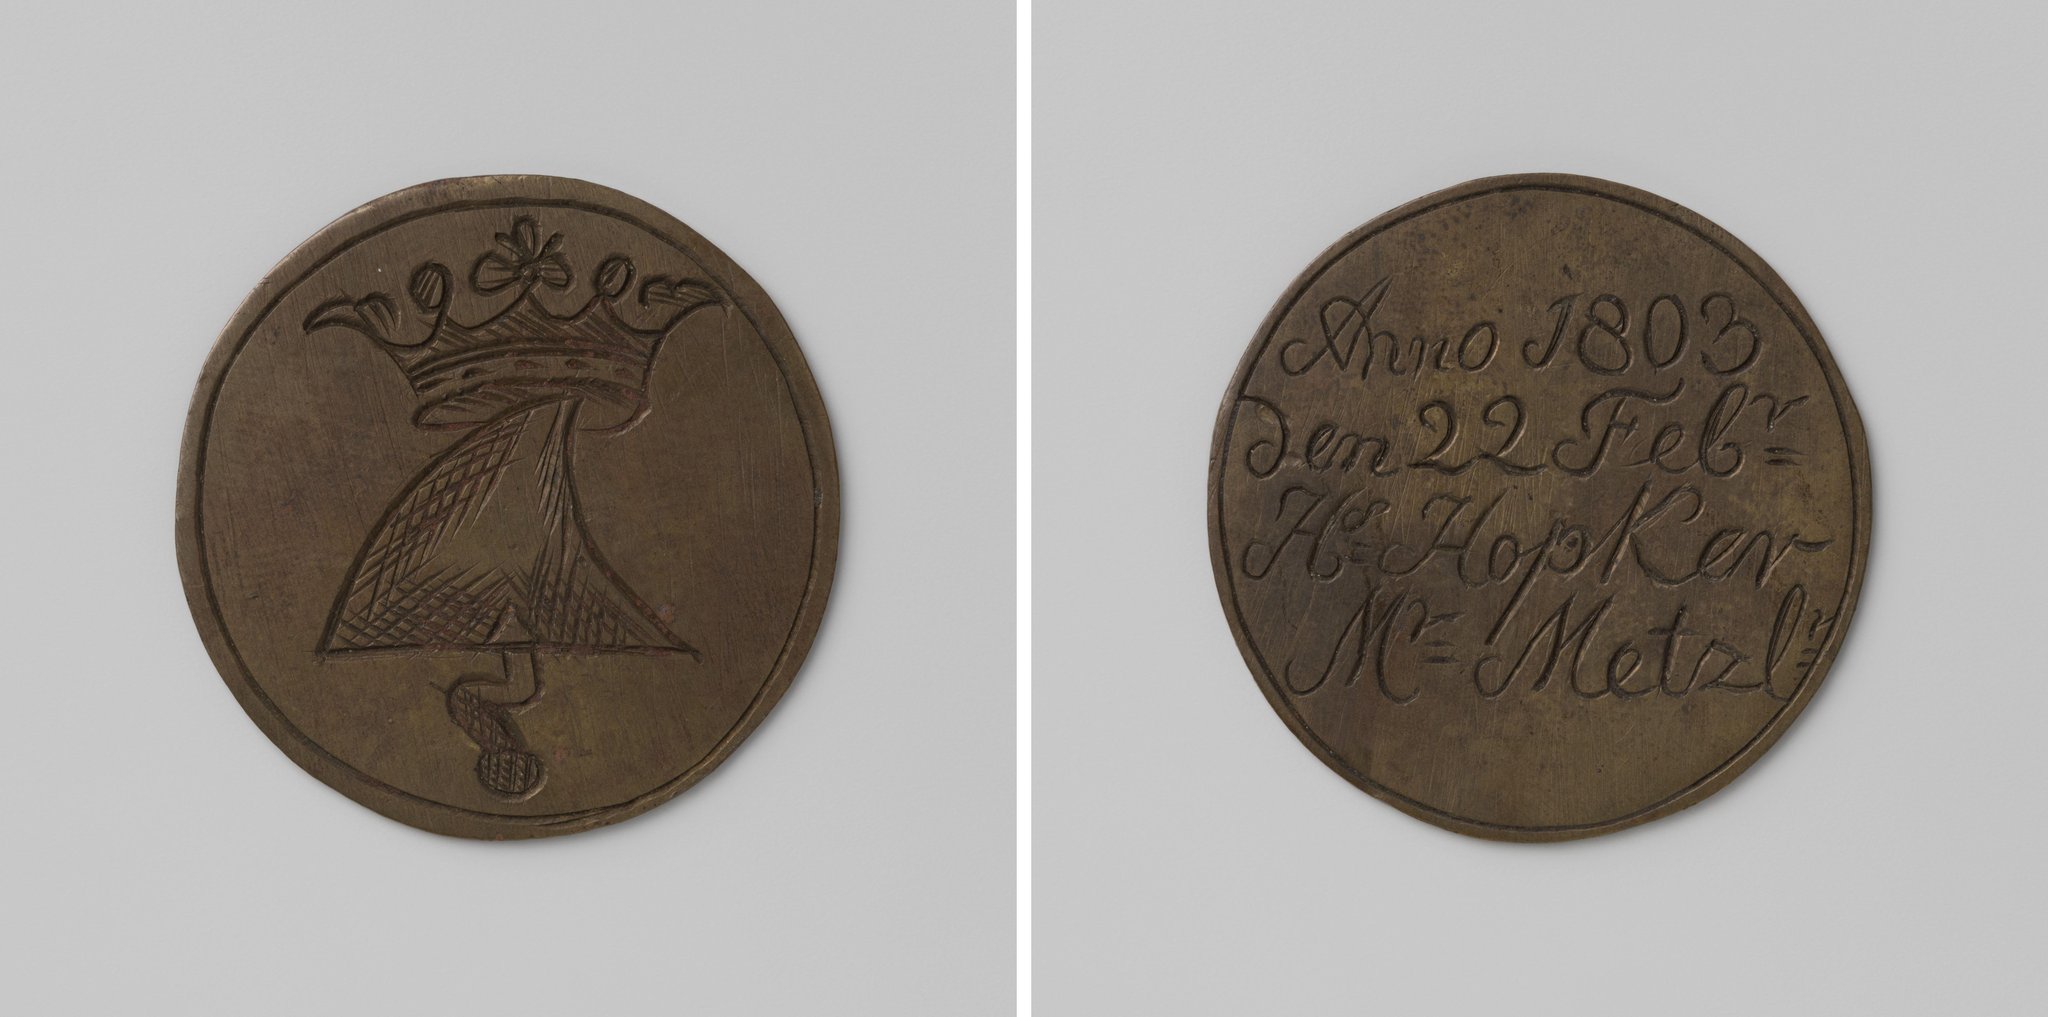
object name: medal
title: Metselaars-, steenhouwers-, leidekkers-, loodgieters- en pompenmakersgilde van Amsterdam, gildepenning van Hs. Hopker, meester metselaar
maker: Anonymous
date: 1803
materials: brass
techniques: engraving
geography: amsterdam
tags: amsterdam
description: Messing penning. Voorzijde: gekroonde, staande troffel. Keerzijde: opschrift